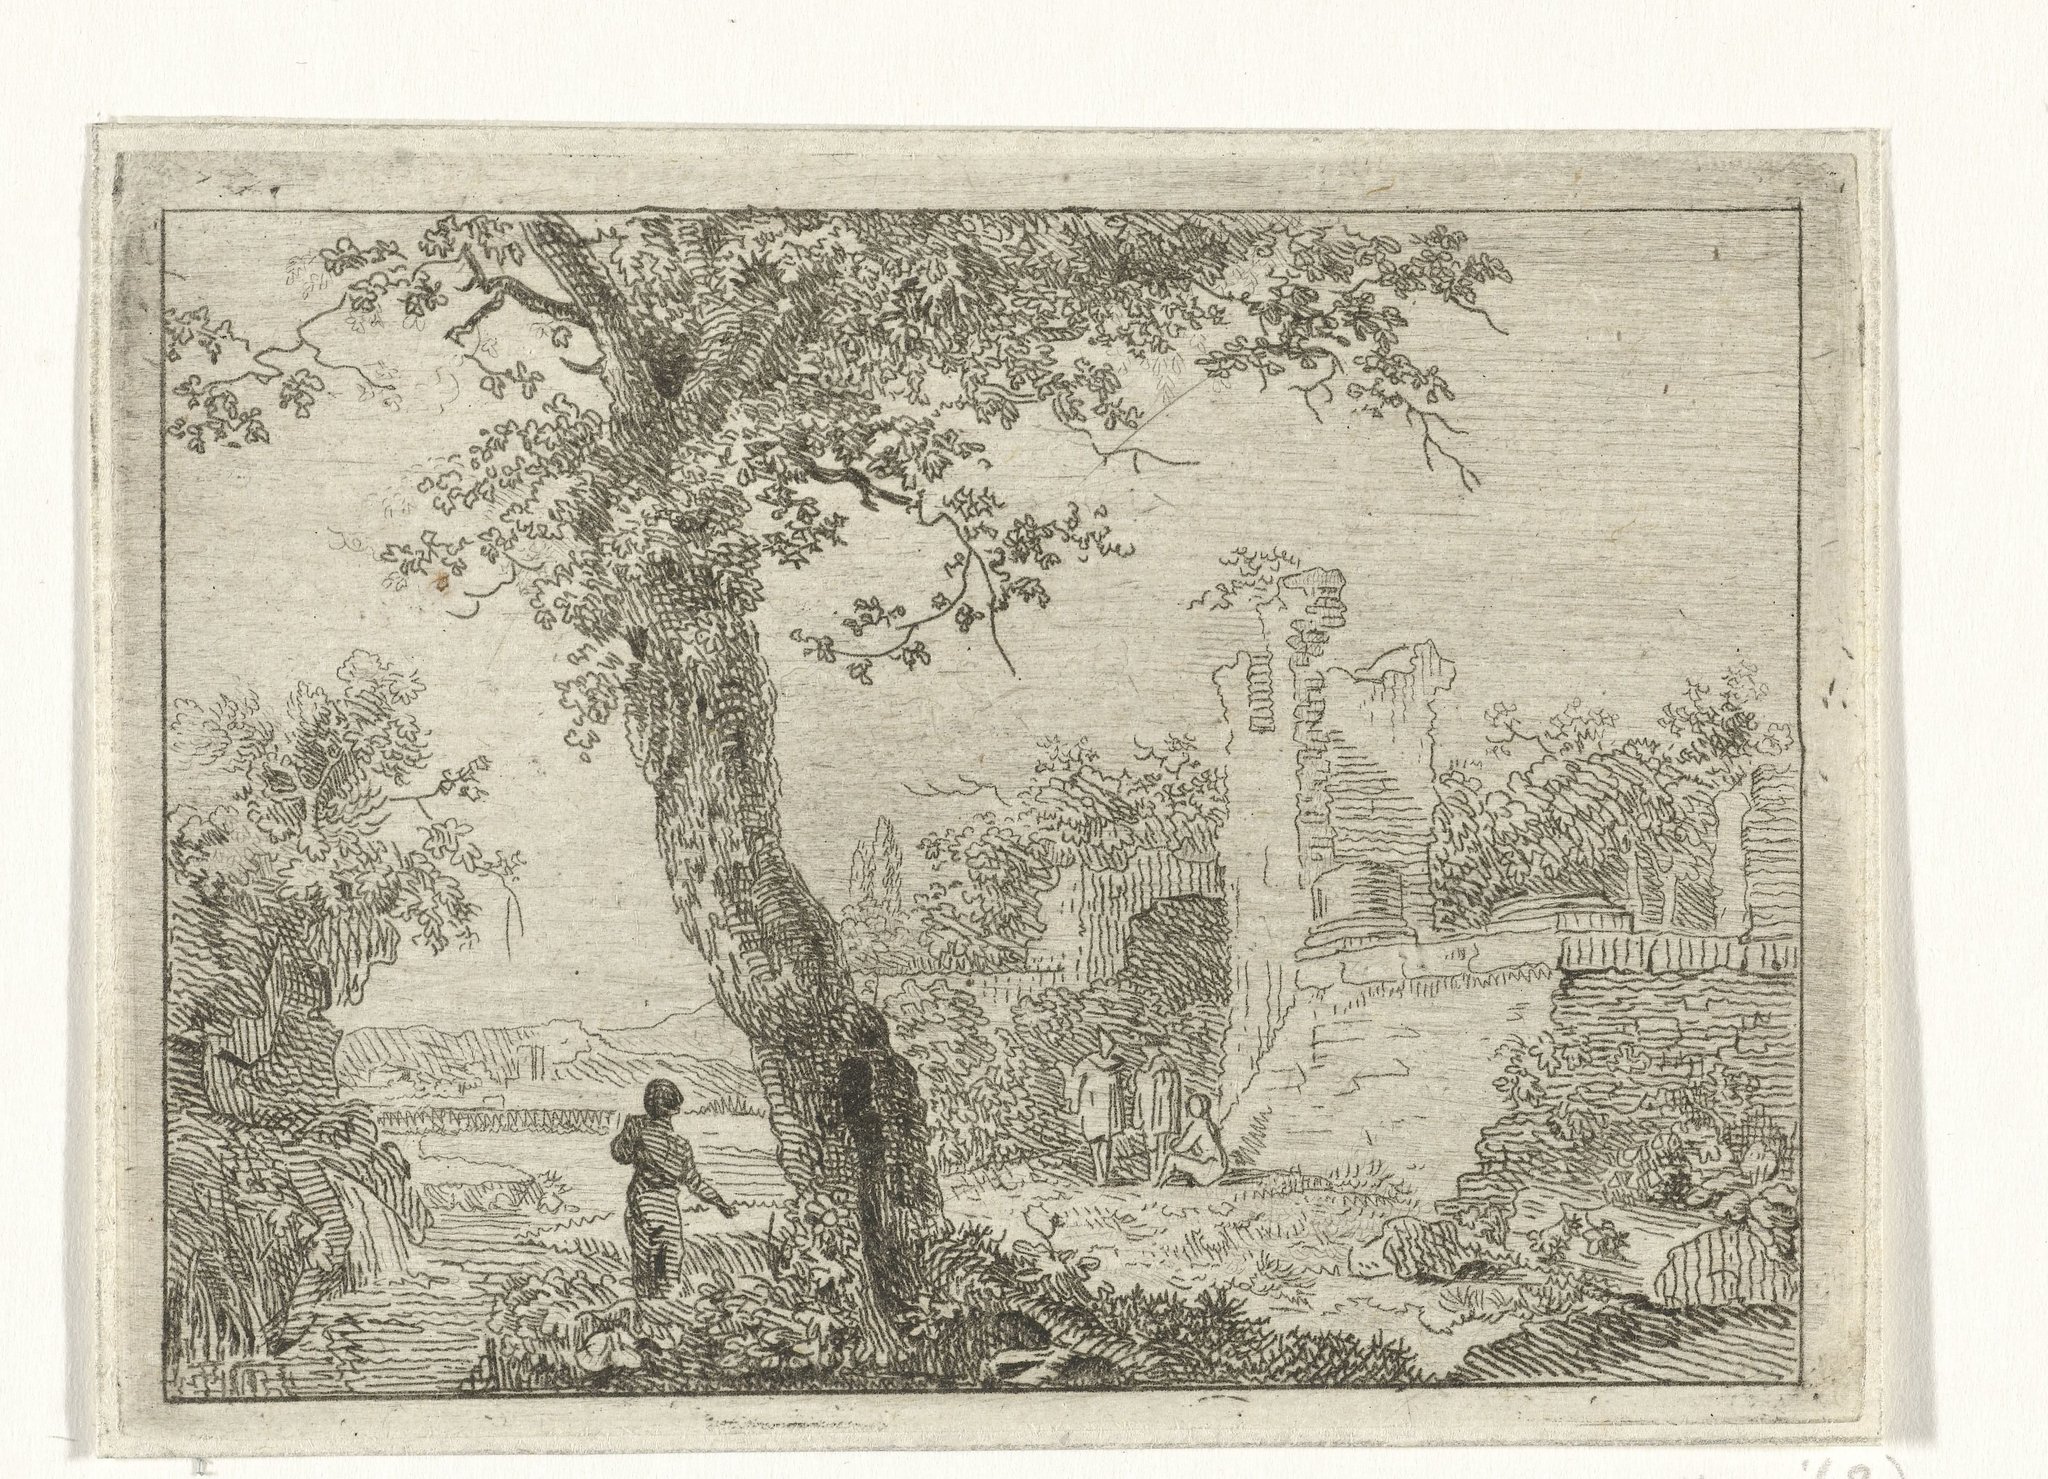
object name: print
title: Landschap met ruïne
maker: Anonymous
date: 1807-1868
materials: paper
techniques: etching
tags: landscape with ruins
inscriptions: collector's mark: Lugt 2228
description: Landschap met ruïne en vier figuren. Op de voorgrond staat een boom.